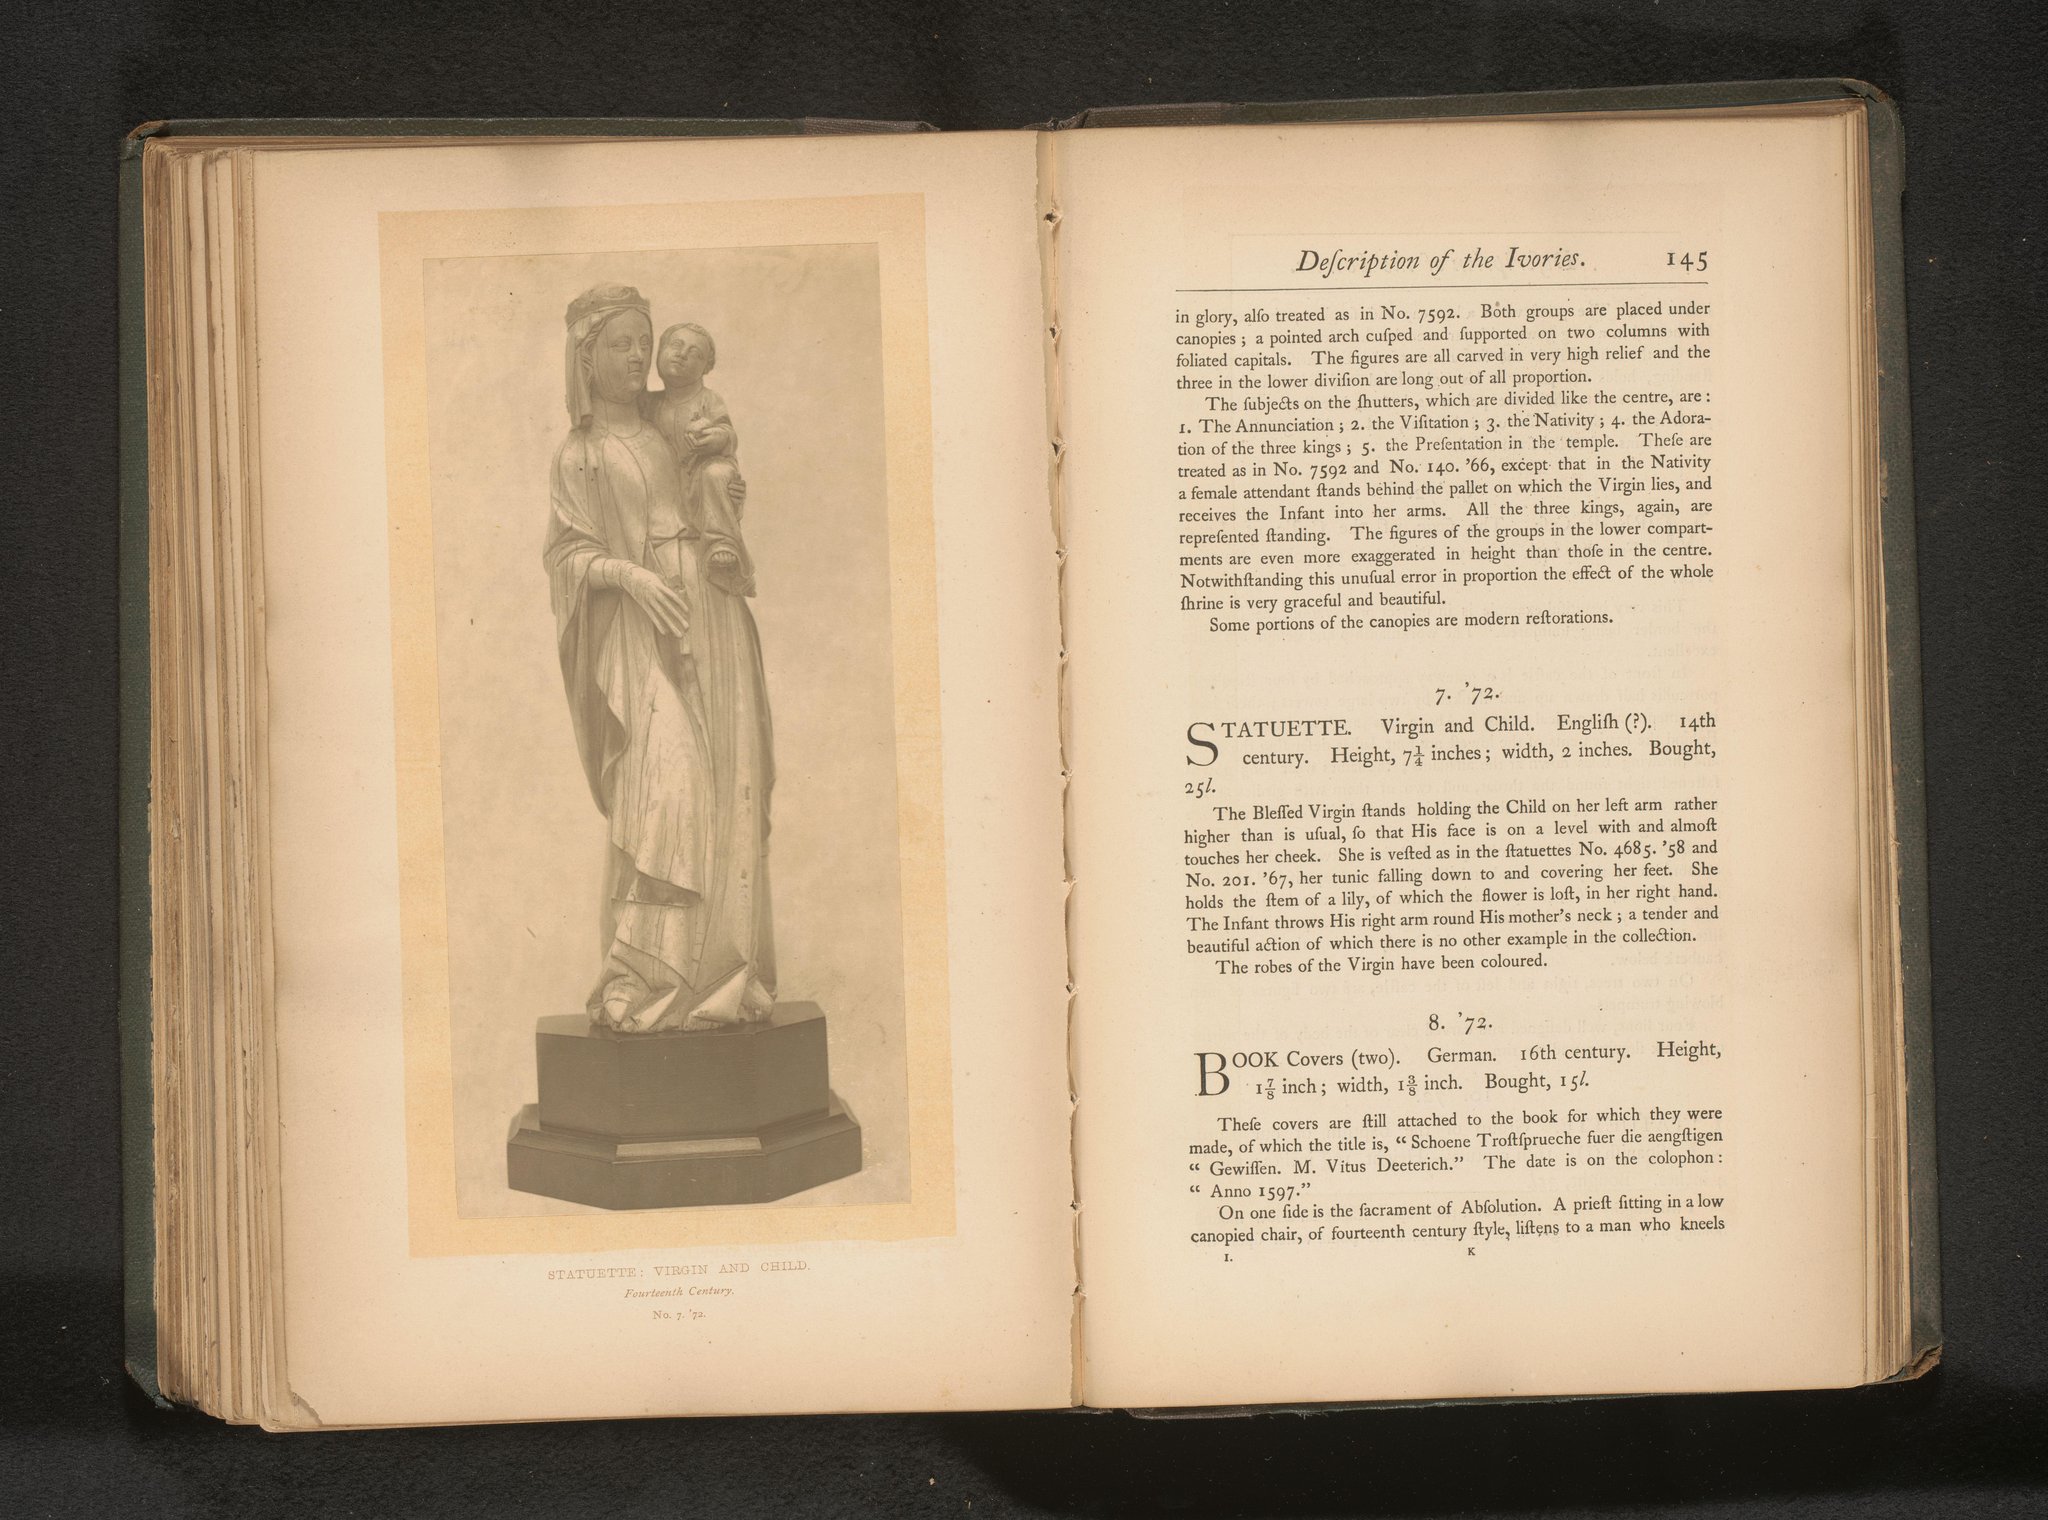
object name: photomechanical print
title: Statuette: Virgin and Child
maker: Anonymous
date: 1867-1872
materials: paper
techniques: woodburytype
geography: london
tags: madonna: i.e. mary with the christ-child, sculpture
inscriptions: inscription: ‘Fourteenth Century.’, number: ‘No. 7 '72.’